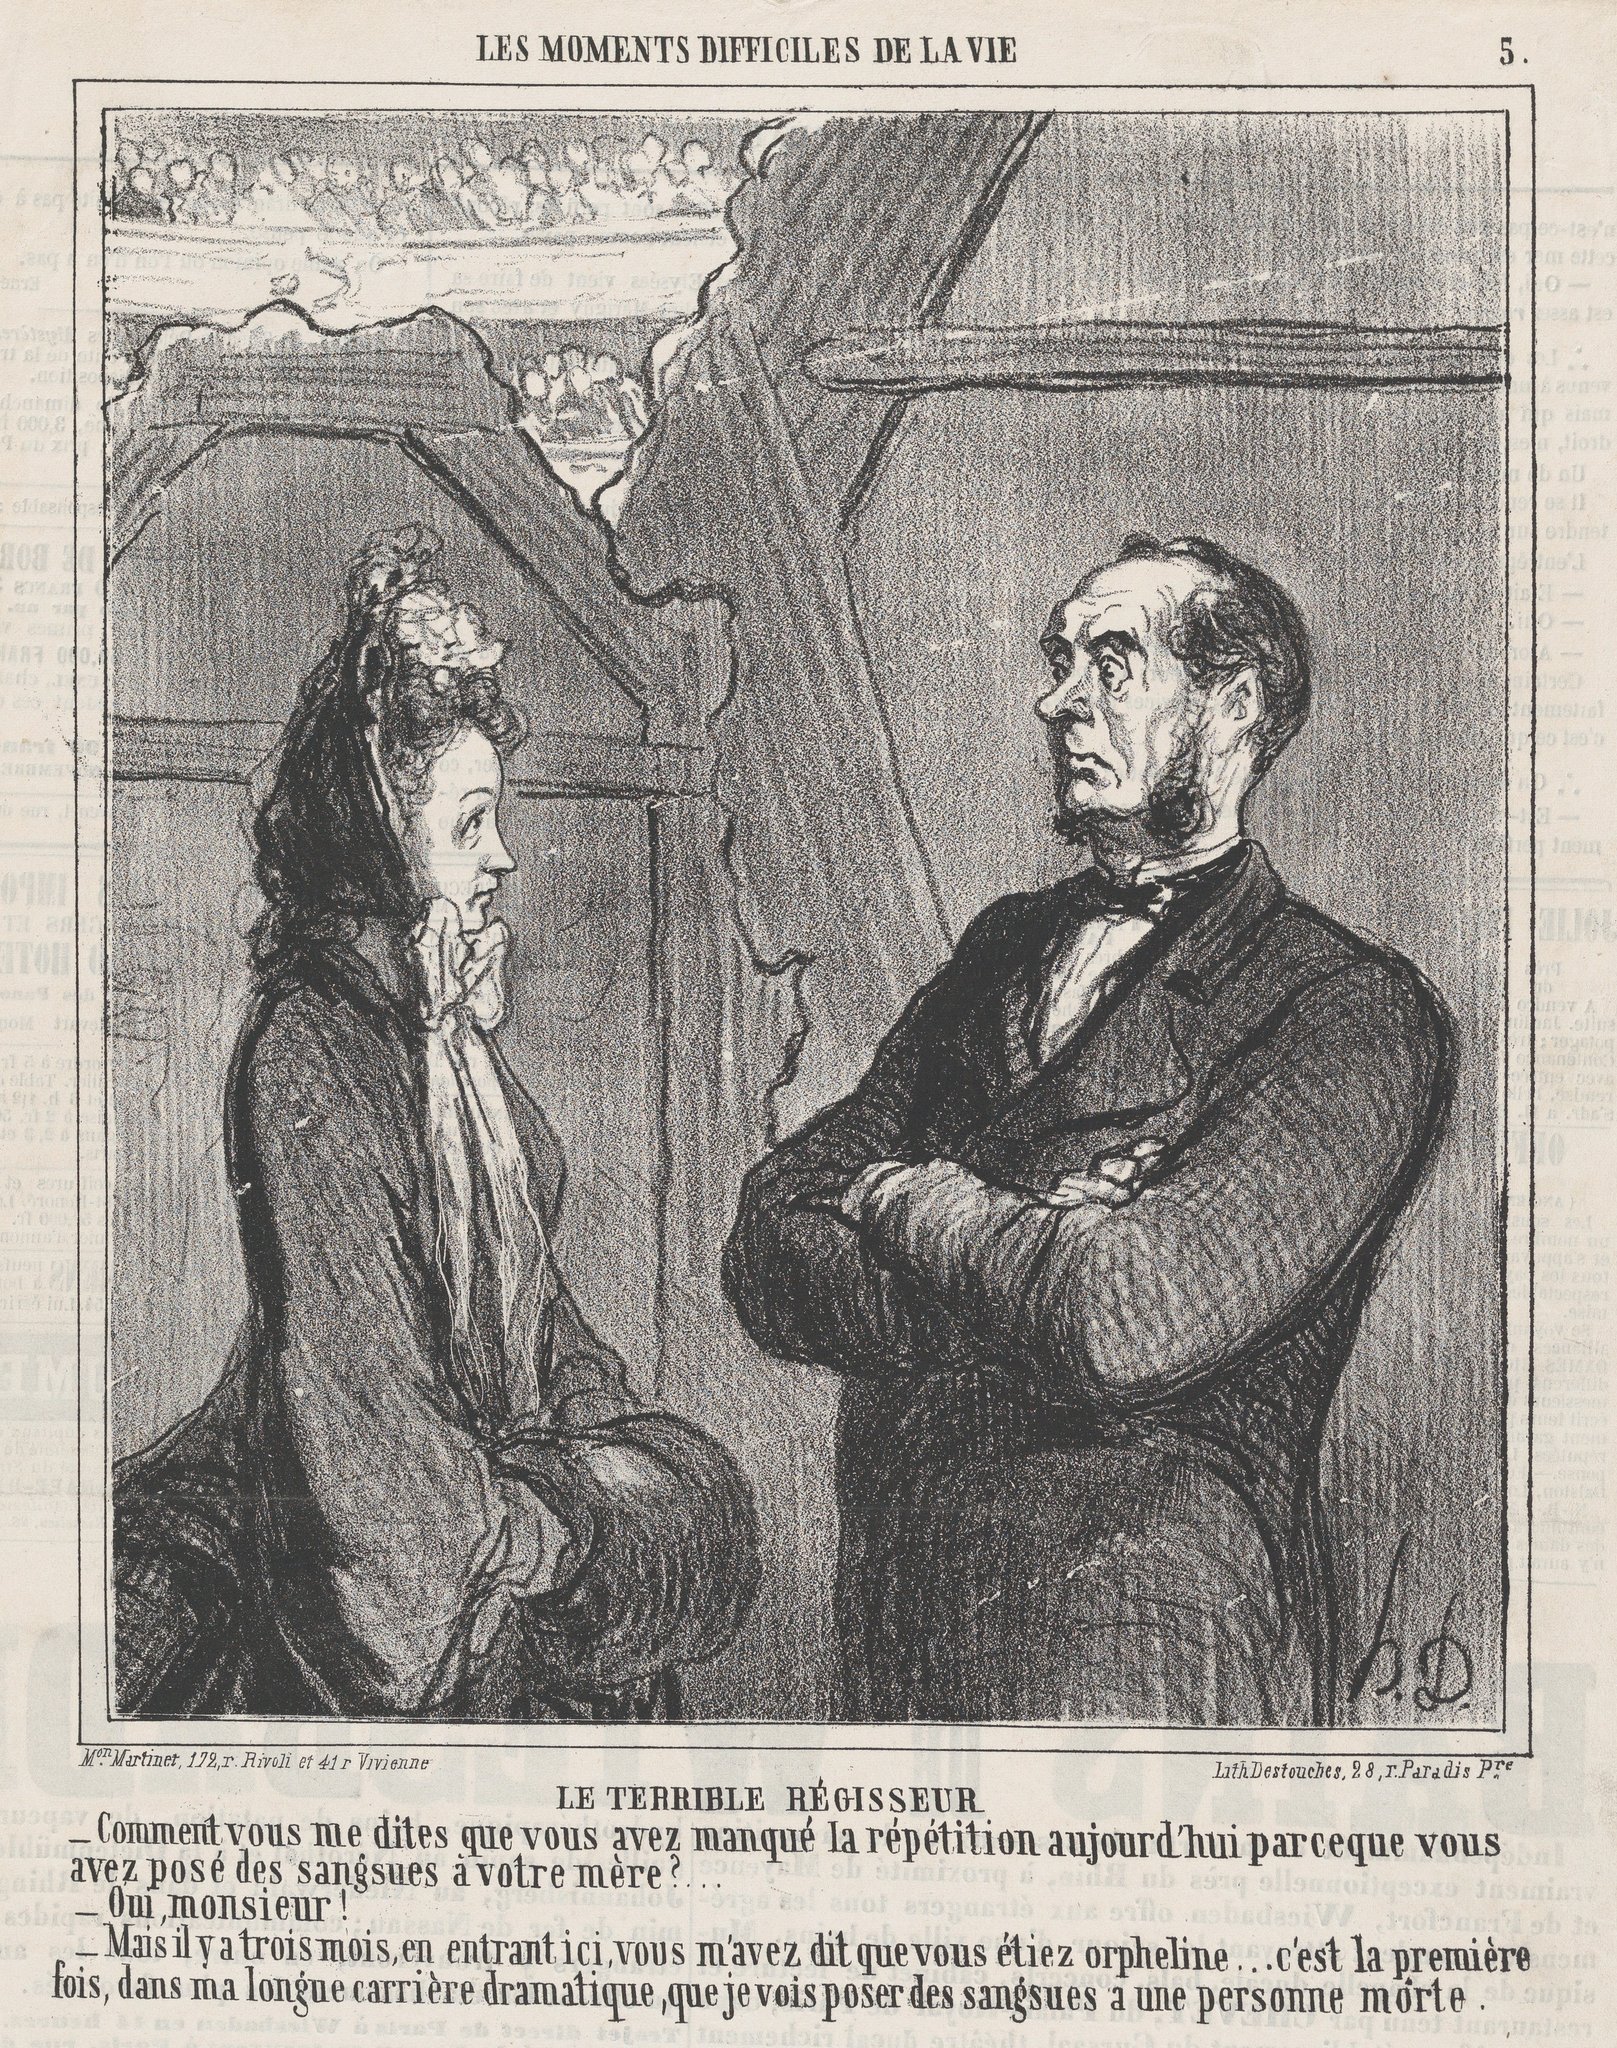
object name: print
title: The terrible director, from 'The difficult moments in life,' published in Le Charivari, April 2, 1864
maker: honoré daumier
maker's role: artist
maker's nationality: french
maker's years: 1808-1879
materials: paper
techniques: lithograph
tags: men,women